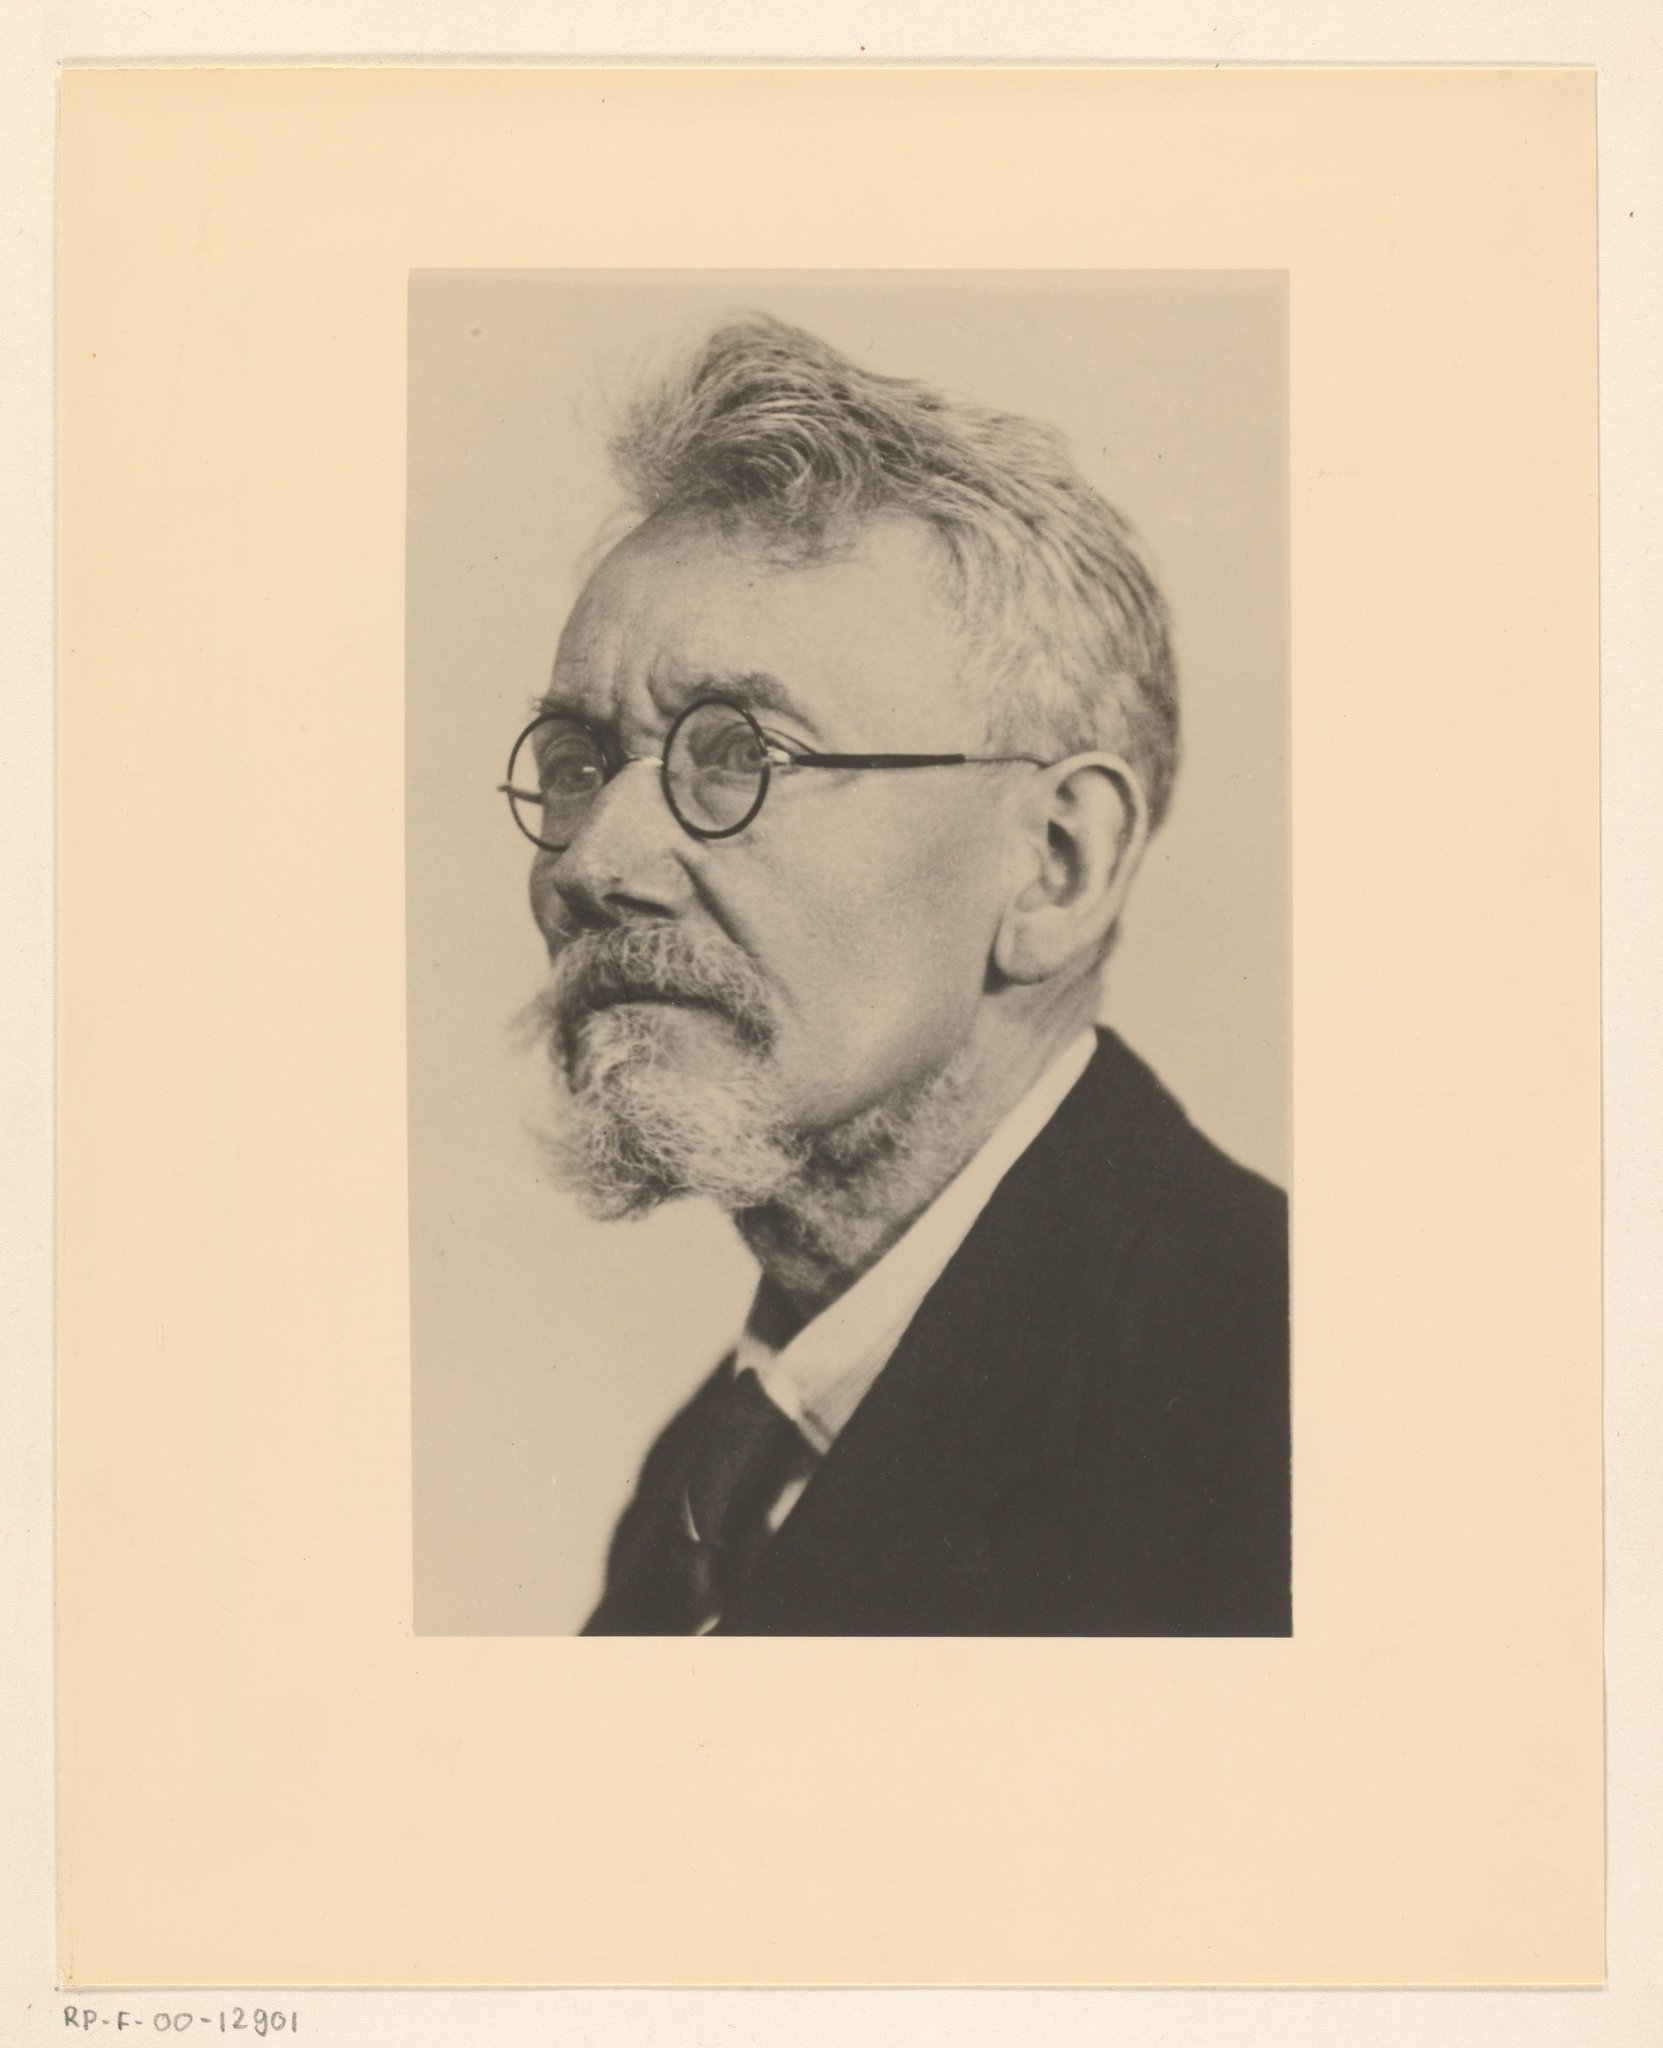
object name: photograph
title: Portret van Max Dittmar Henkel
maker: Anonymous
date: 1905-1943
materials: paper, cardboard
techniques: gelatin silver print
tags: max dittmar henkel, historical persons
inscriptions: inscription: ‘M.D. Henkel/ 1879-1944/ Photo genomen Mei 1943’